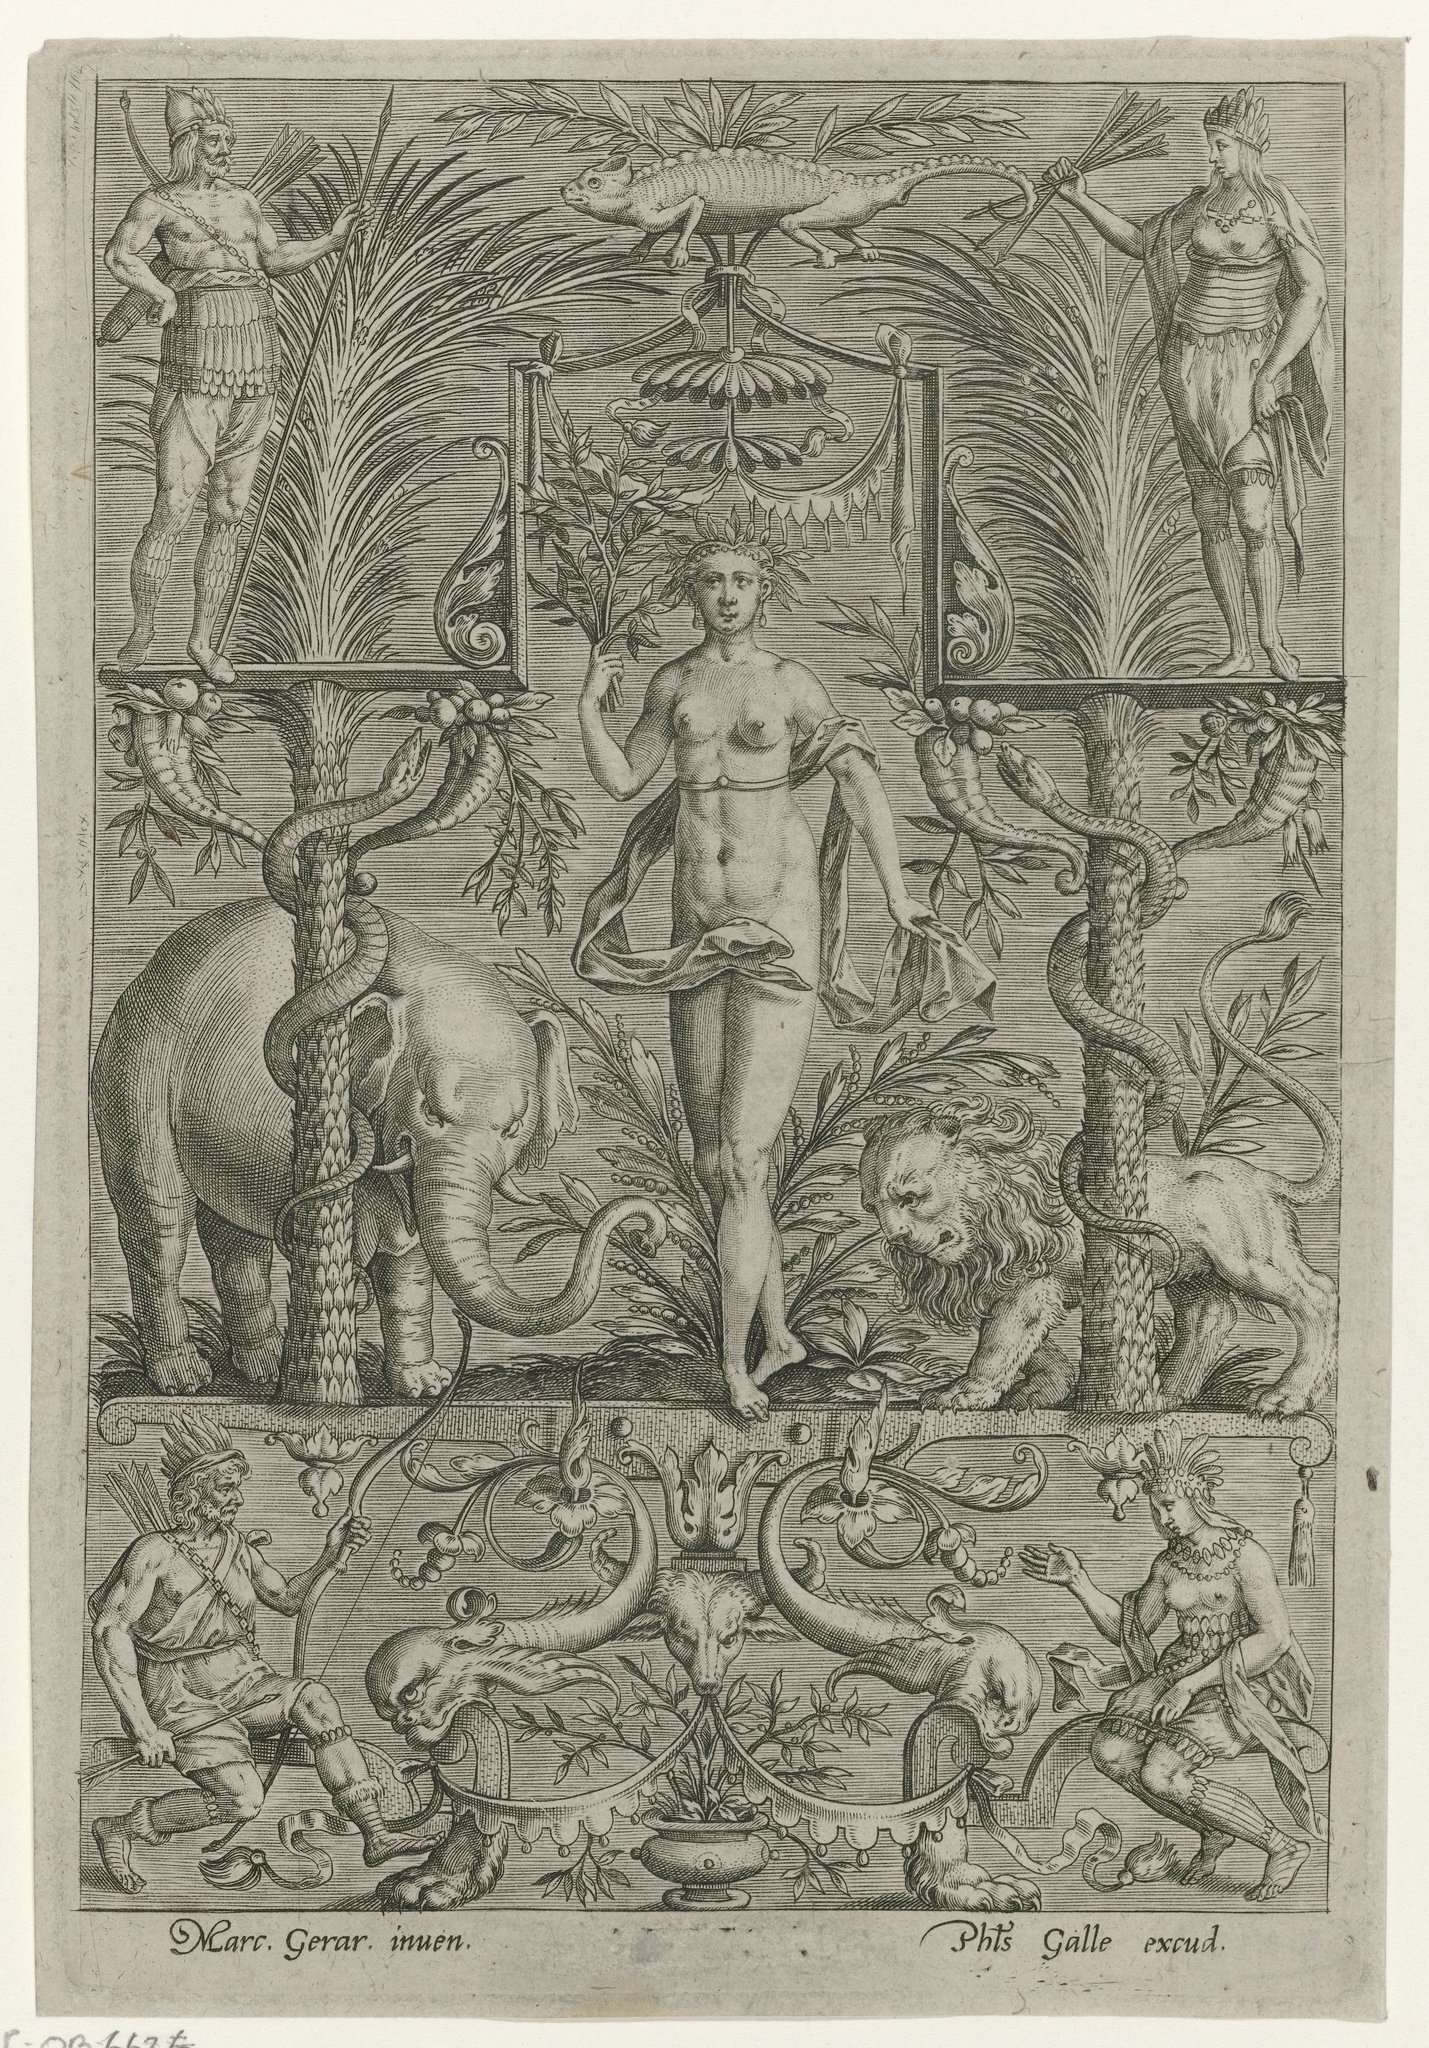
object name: print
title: Africa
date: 1547-1622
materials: paper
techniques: engraving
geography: bruges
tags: ornament ~ arabesque, africa represented allegorically; 'africa' (ripa)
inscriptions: collector's mark: Lugt 2228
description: De personificatie van Afrika, staande op een sokkel omringd door ornamentele versieringen. Ze heeft een takkebos in haar handen en wordt geflankeerd door een olifant en een leeuw. Boven haar een kameleon en twee Afrikanen. Onderaan de prent twee zeemonsters. De prent is deel van een reeks over de vier werelddelen.